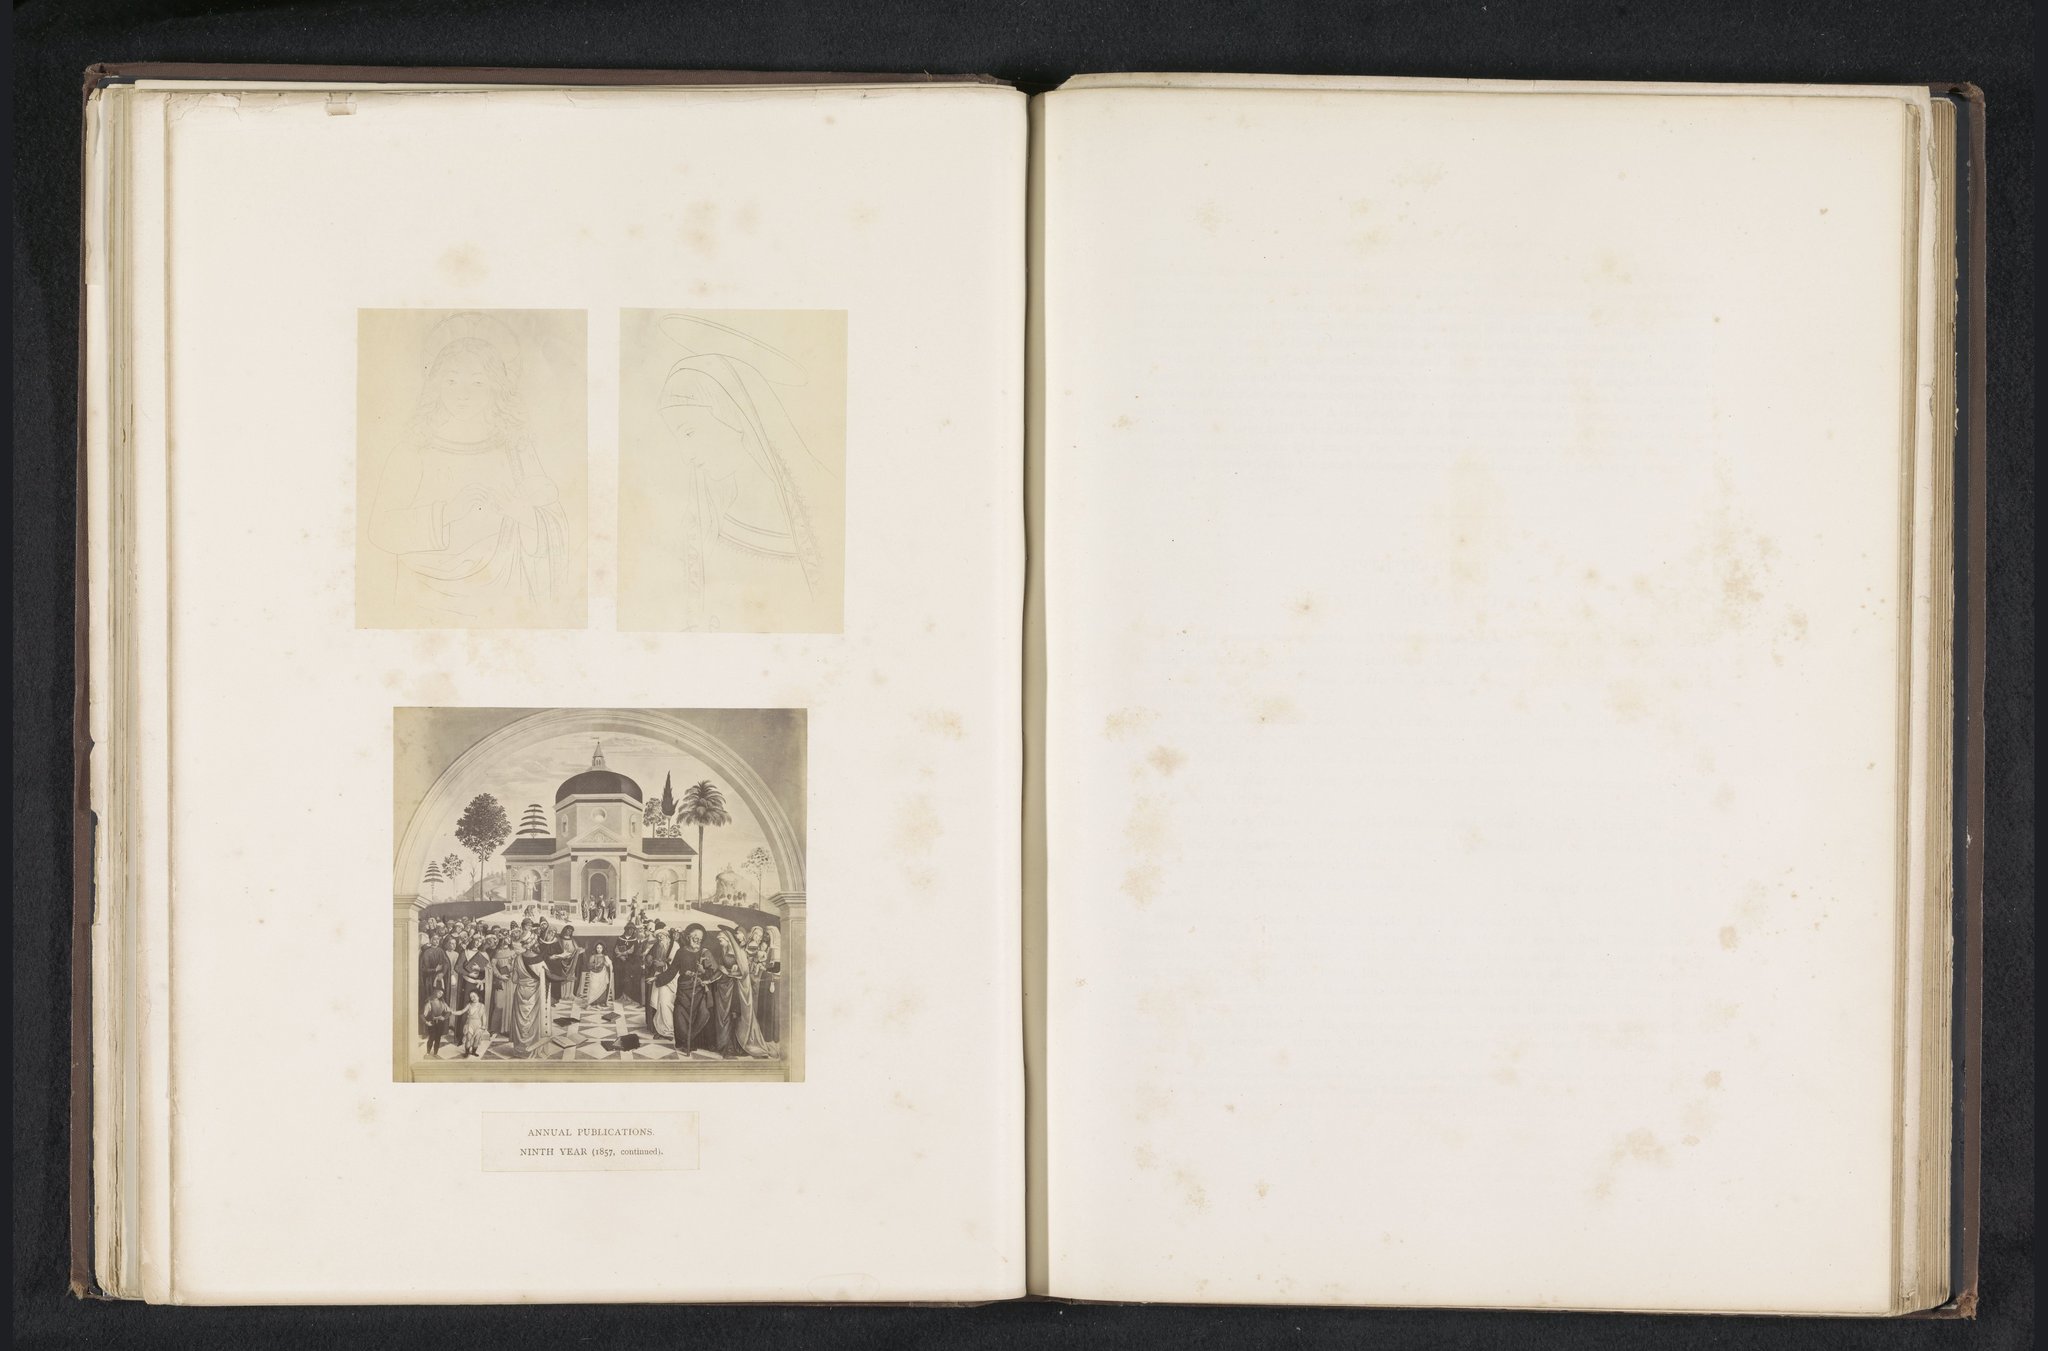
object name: page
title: Drie fotoreproducties van een publicatie door de Arundel Society met afbeeldingen door Pinturicchio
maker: Anonymous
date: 1859-1869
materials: photographic support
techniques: albumen print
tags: christ's dispute with the doctors in the temple; he counts his arguments on his fingers, book, painting (including book-illumination, miniature-painting)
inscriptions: inscription: ‘Annual publications. Ninth year (1857, continued).’